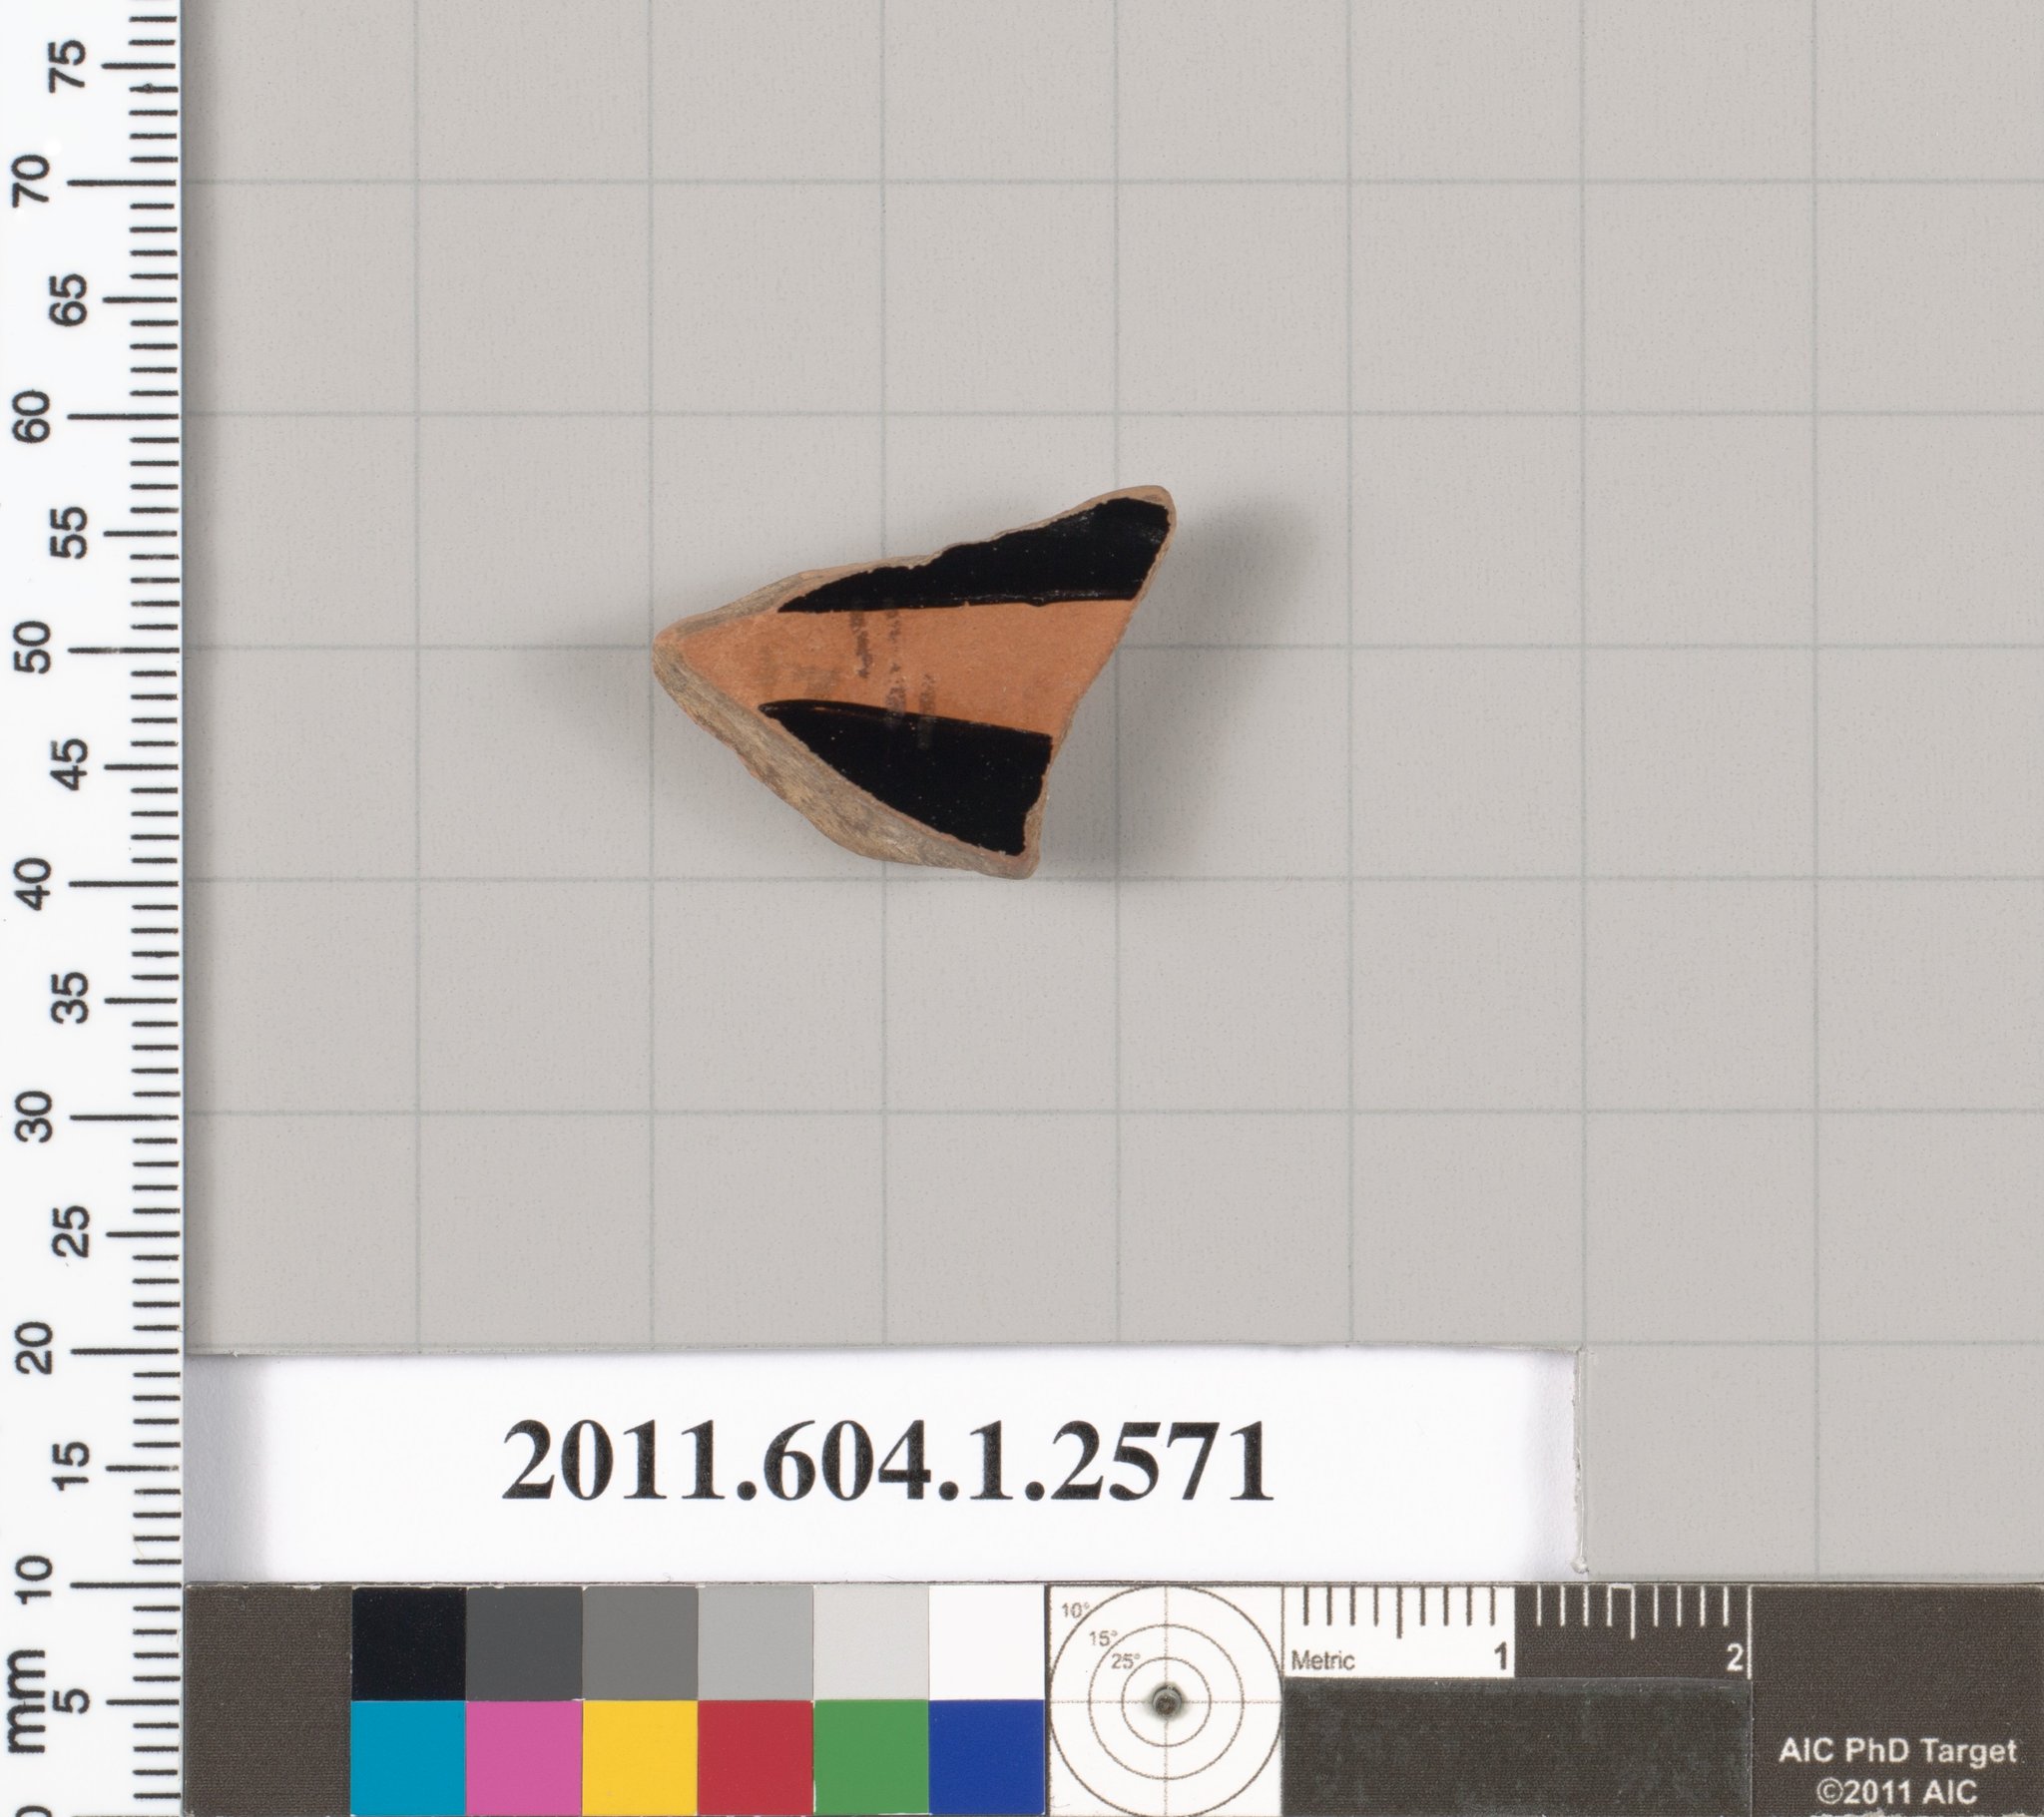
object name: kylix fragment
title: Terracotta fragment of a kylix (drinking cup)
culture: greek, attic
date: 490-480 BCE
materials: terracotta